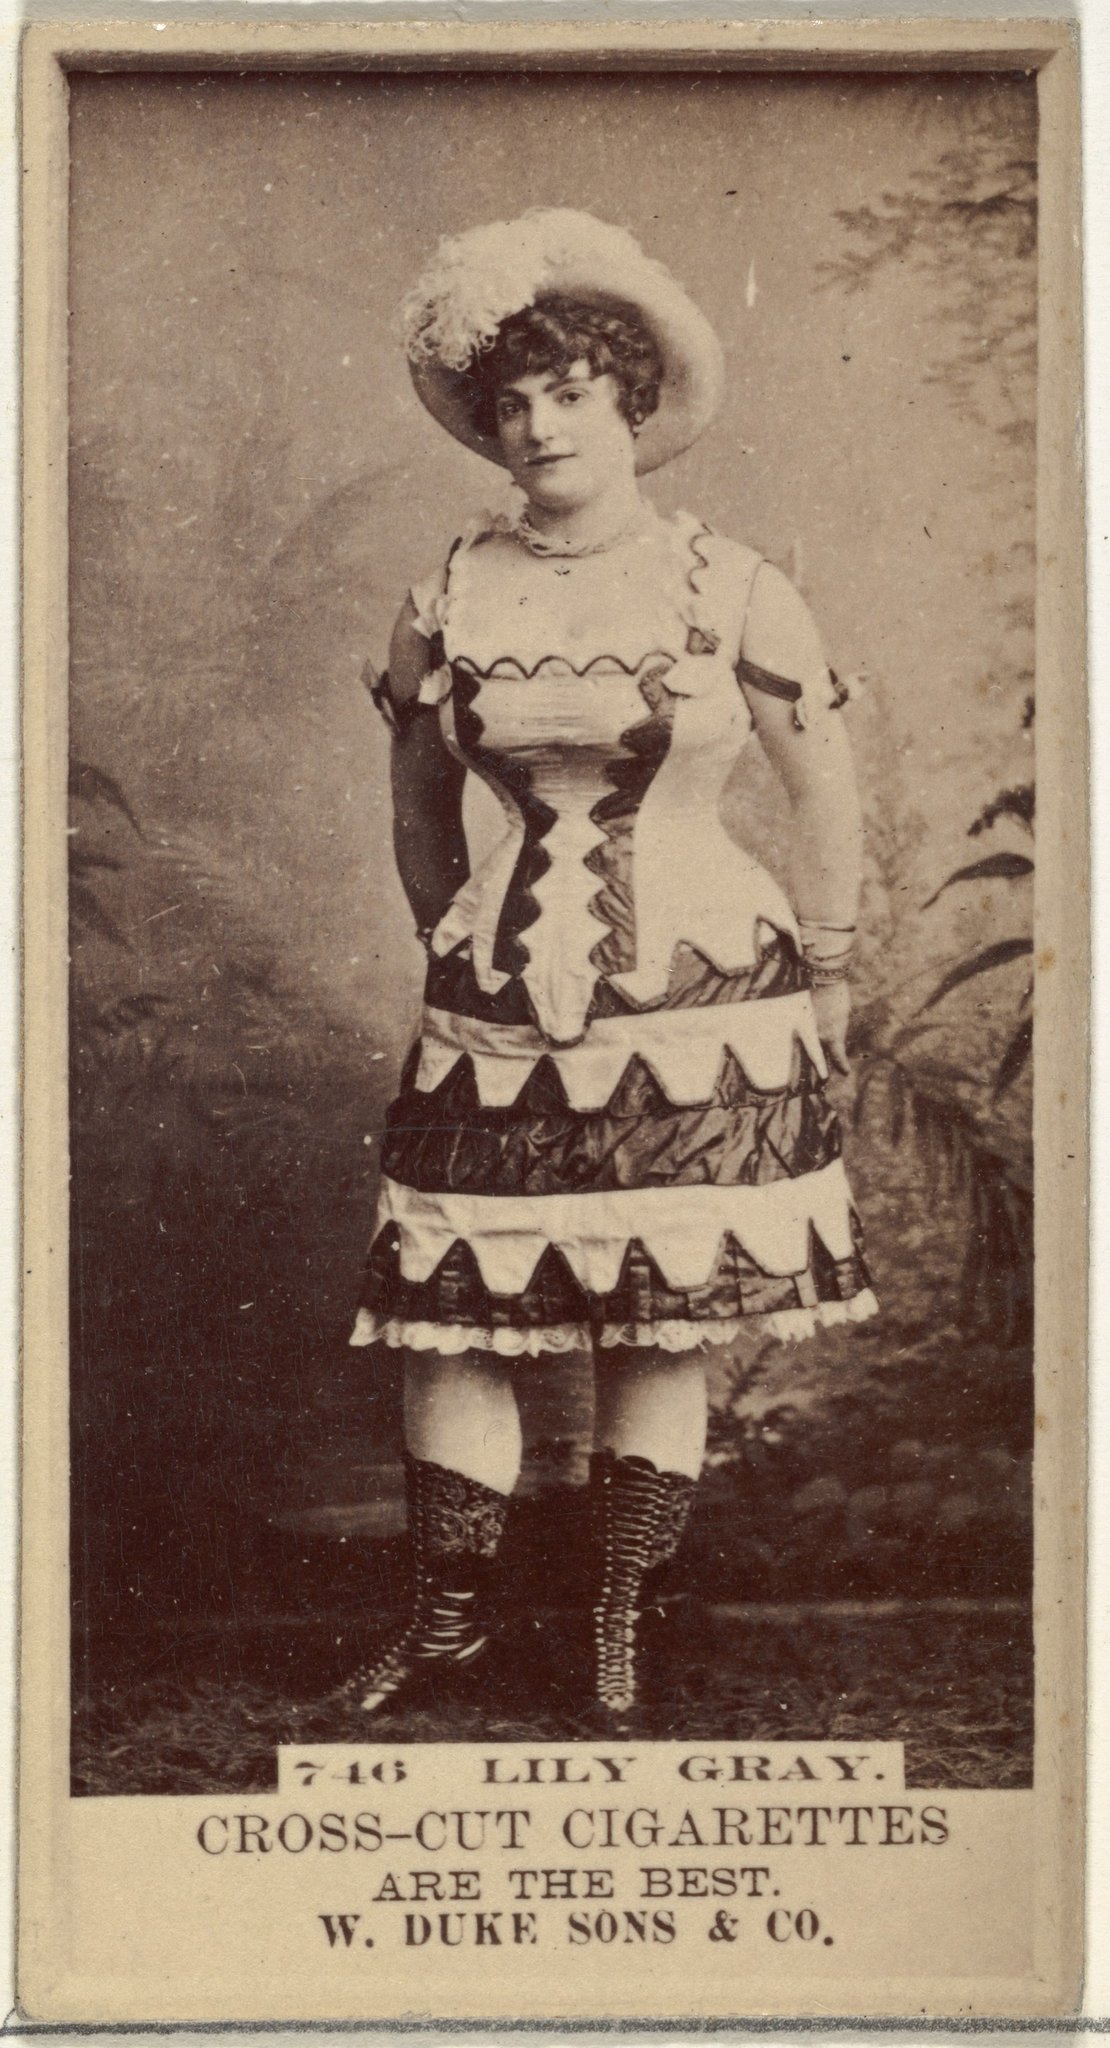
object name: photograph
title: Card Number 746, Lily Gray, from the Actors and Actresses series (N145-3) issued by Duke Sons & Co. to promote Cross Cut Cigarettes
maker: w. duke, sons & co.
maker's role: publisher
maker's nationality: american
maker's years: 1870-1920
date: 1880-1889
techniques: albumen silver print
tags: portraits,women,actresses